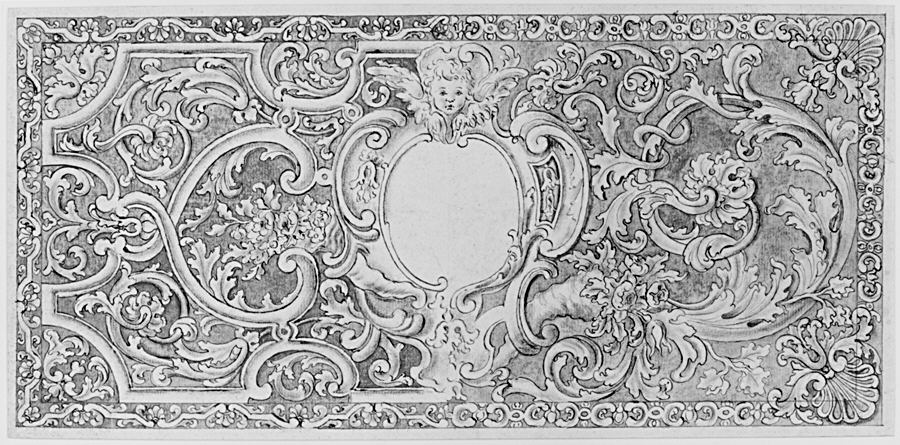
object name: drawing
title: Architect's Sketchbook and Sourcebook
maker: ferdinando galli bibiena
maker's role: artist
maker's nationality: italian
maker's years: 1657-1743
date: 1700-1743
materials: ink, drawing material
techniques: brush, pen, wash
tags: ornament